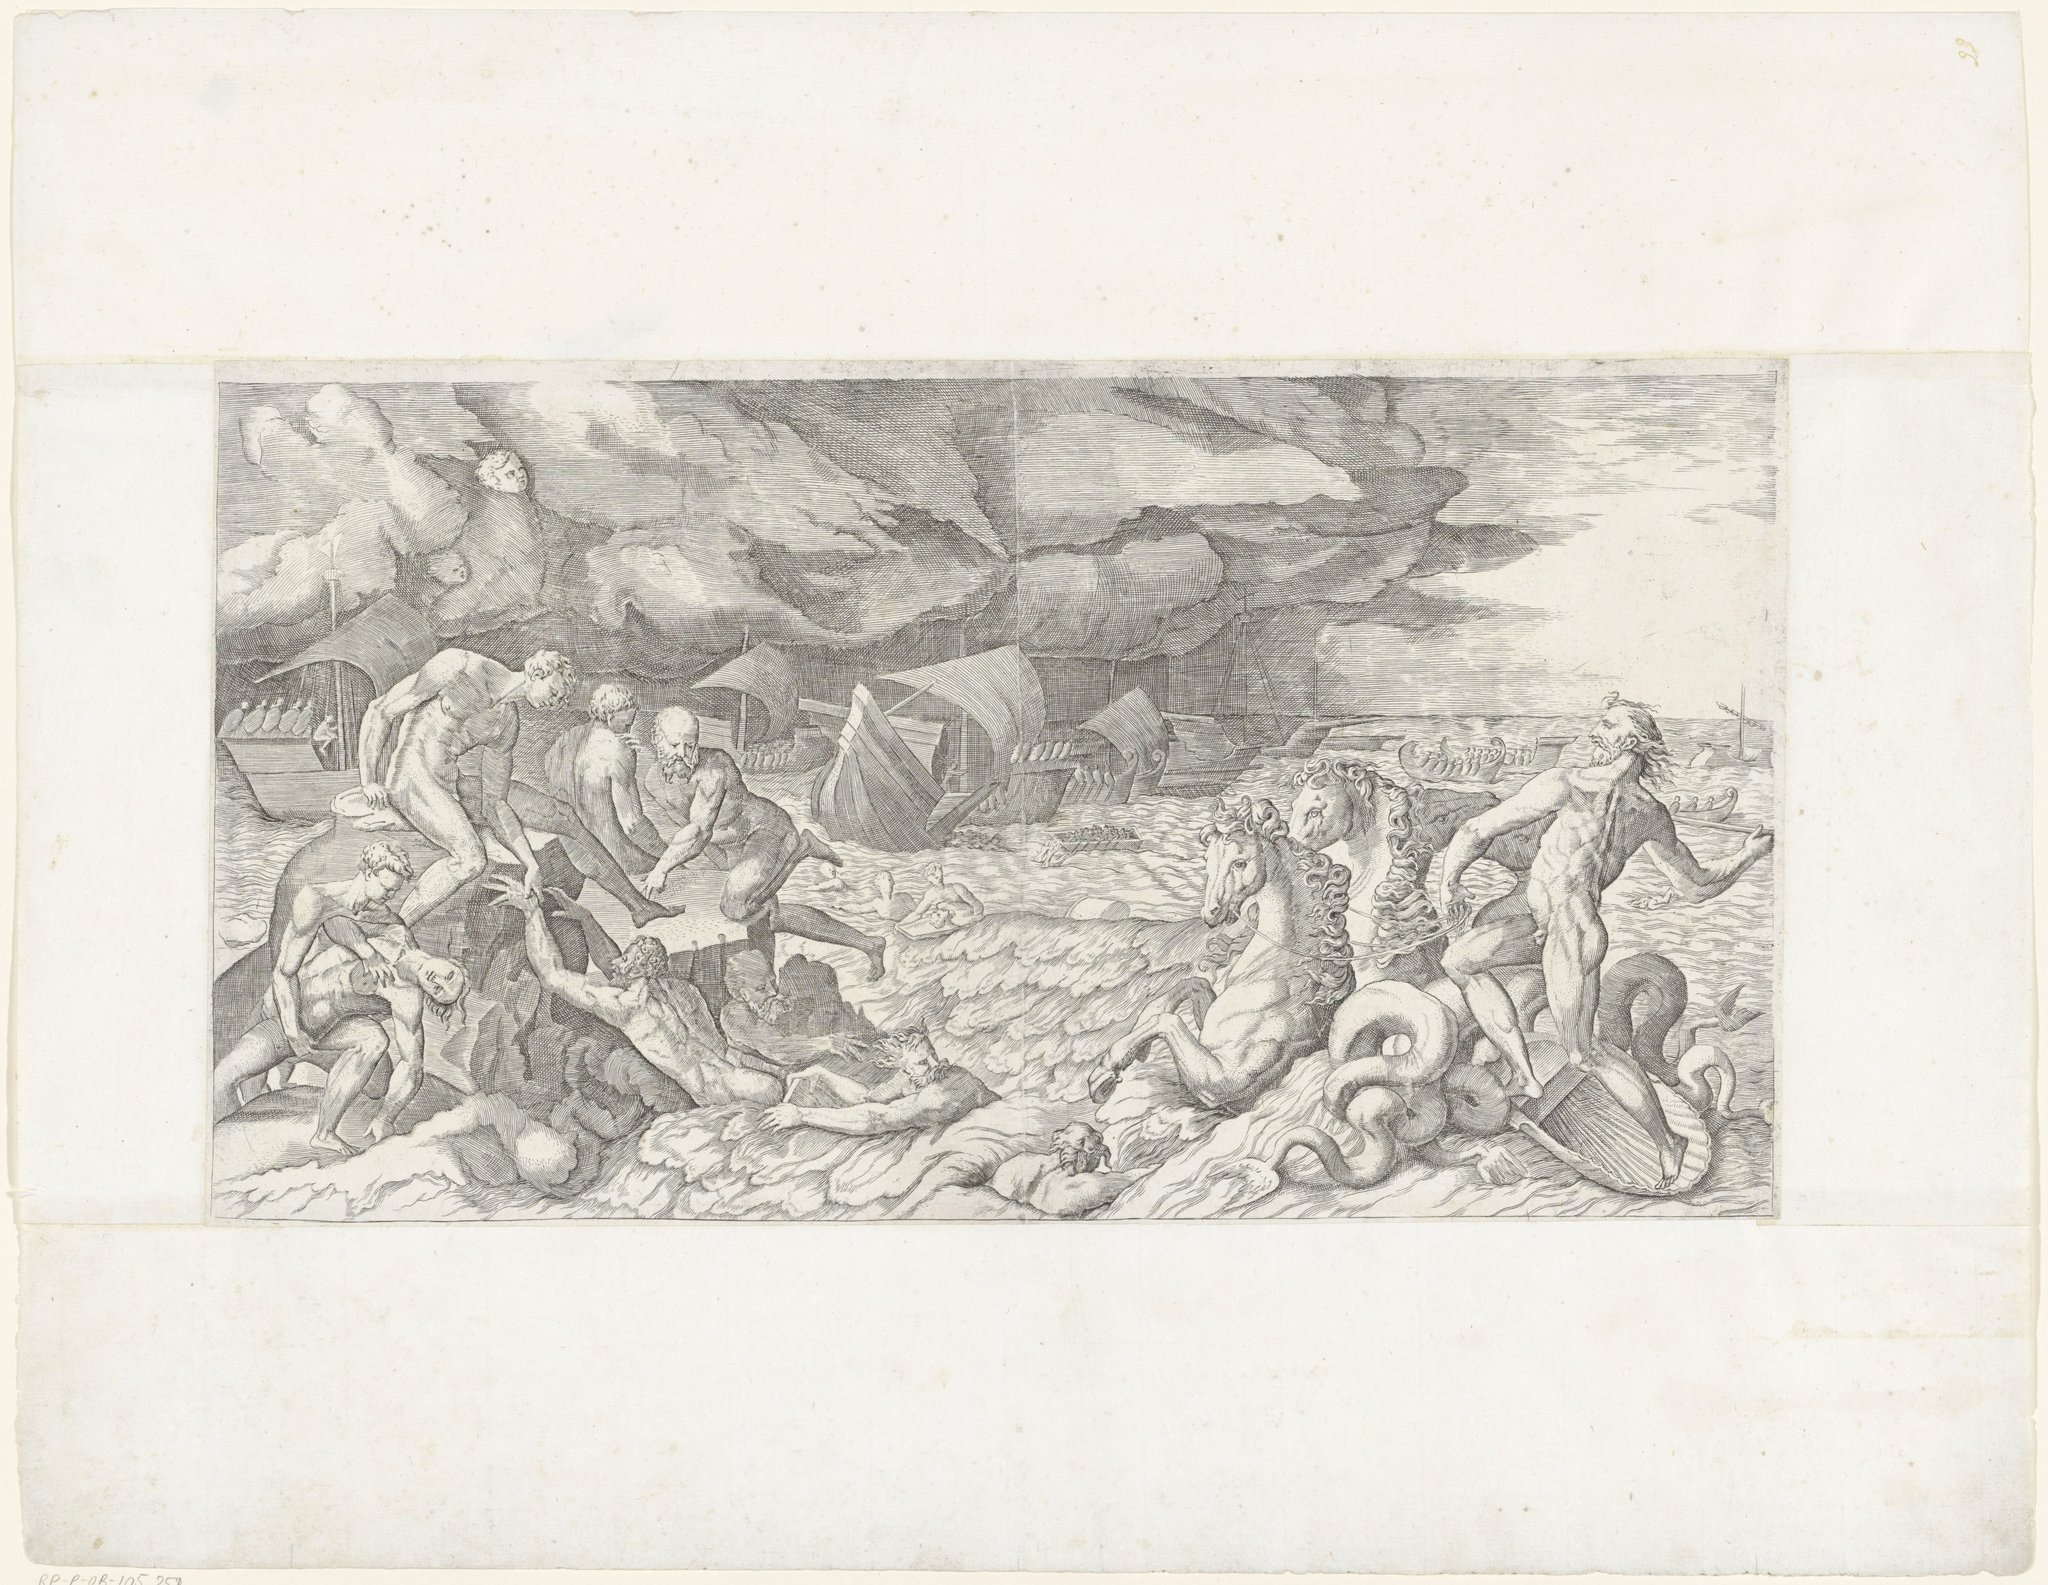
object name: album leaf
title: Neptunus kalmeert de golven (‘Quos Ego’)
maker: giulio bonasone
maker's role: painter, print maker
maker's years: 1510-1576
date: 1531-1570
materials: paper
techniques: engraving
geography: italy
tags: neptune quieting the storm, 'quos ego' (virgil, aeneid i 135)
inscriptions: watermark, collector's mark: Lugt 2760, watermark, collector's mark: Lugt 2228, number: ‘66’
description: Folio 66 uit het prentalbum van Johann Georg I. Zobel von Giebelstadt (Röttingen 1543-07-20 - Bamberg 1580-09-07), de latere bisschop van Bamberg. Het album is vermoedelijk samengesteld tussen 1568 en 1570 in Venetië. Het album werd in 1999 uit elkaar genomen door een antiquair. De in totaal 124 folio's met prenten uit het "Zobel Album" werden aangekocht door verschillende musea en privéverzamelingen. De grootste groep (68 folio's) bevindt zich in de collectie van het Rijksmuseum. Naar een tekening van Perino del Vaga (Parijs, Louvre, inv. nr.: 636 recto). Naar het verloren gegaan fresco van Del Vaga in Palazzo Doria te Genua.